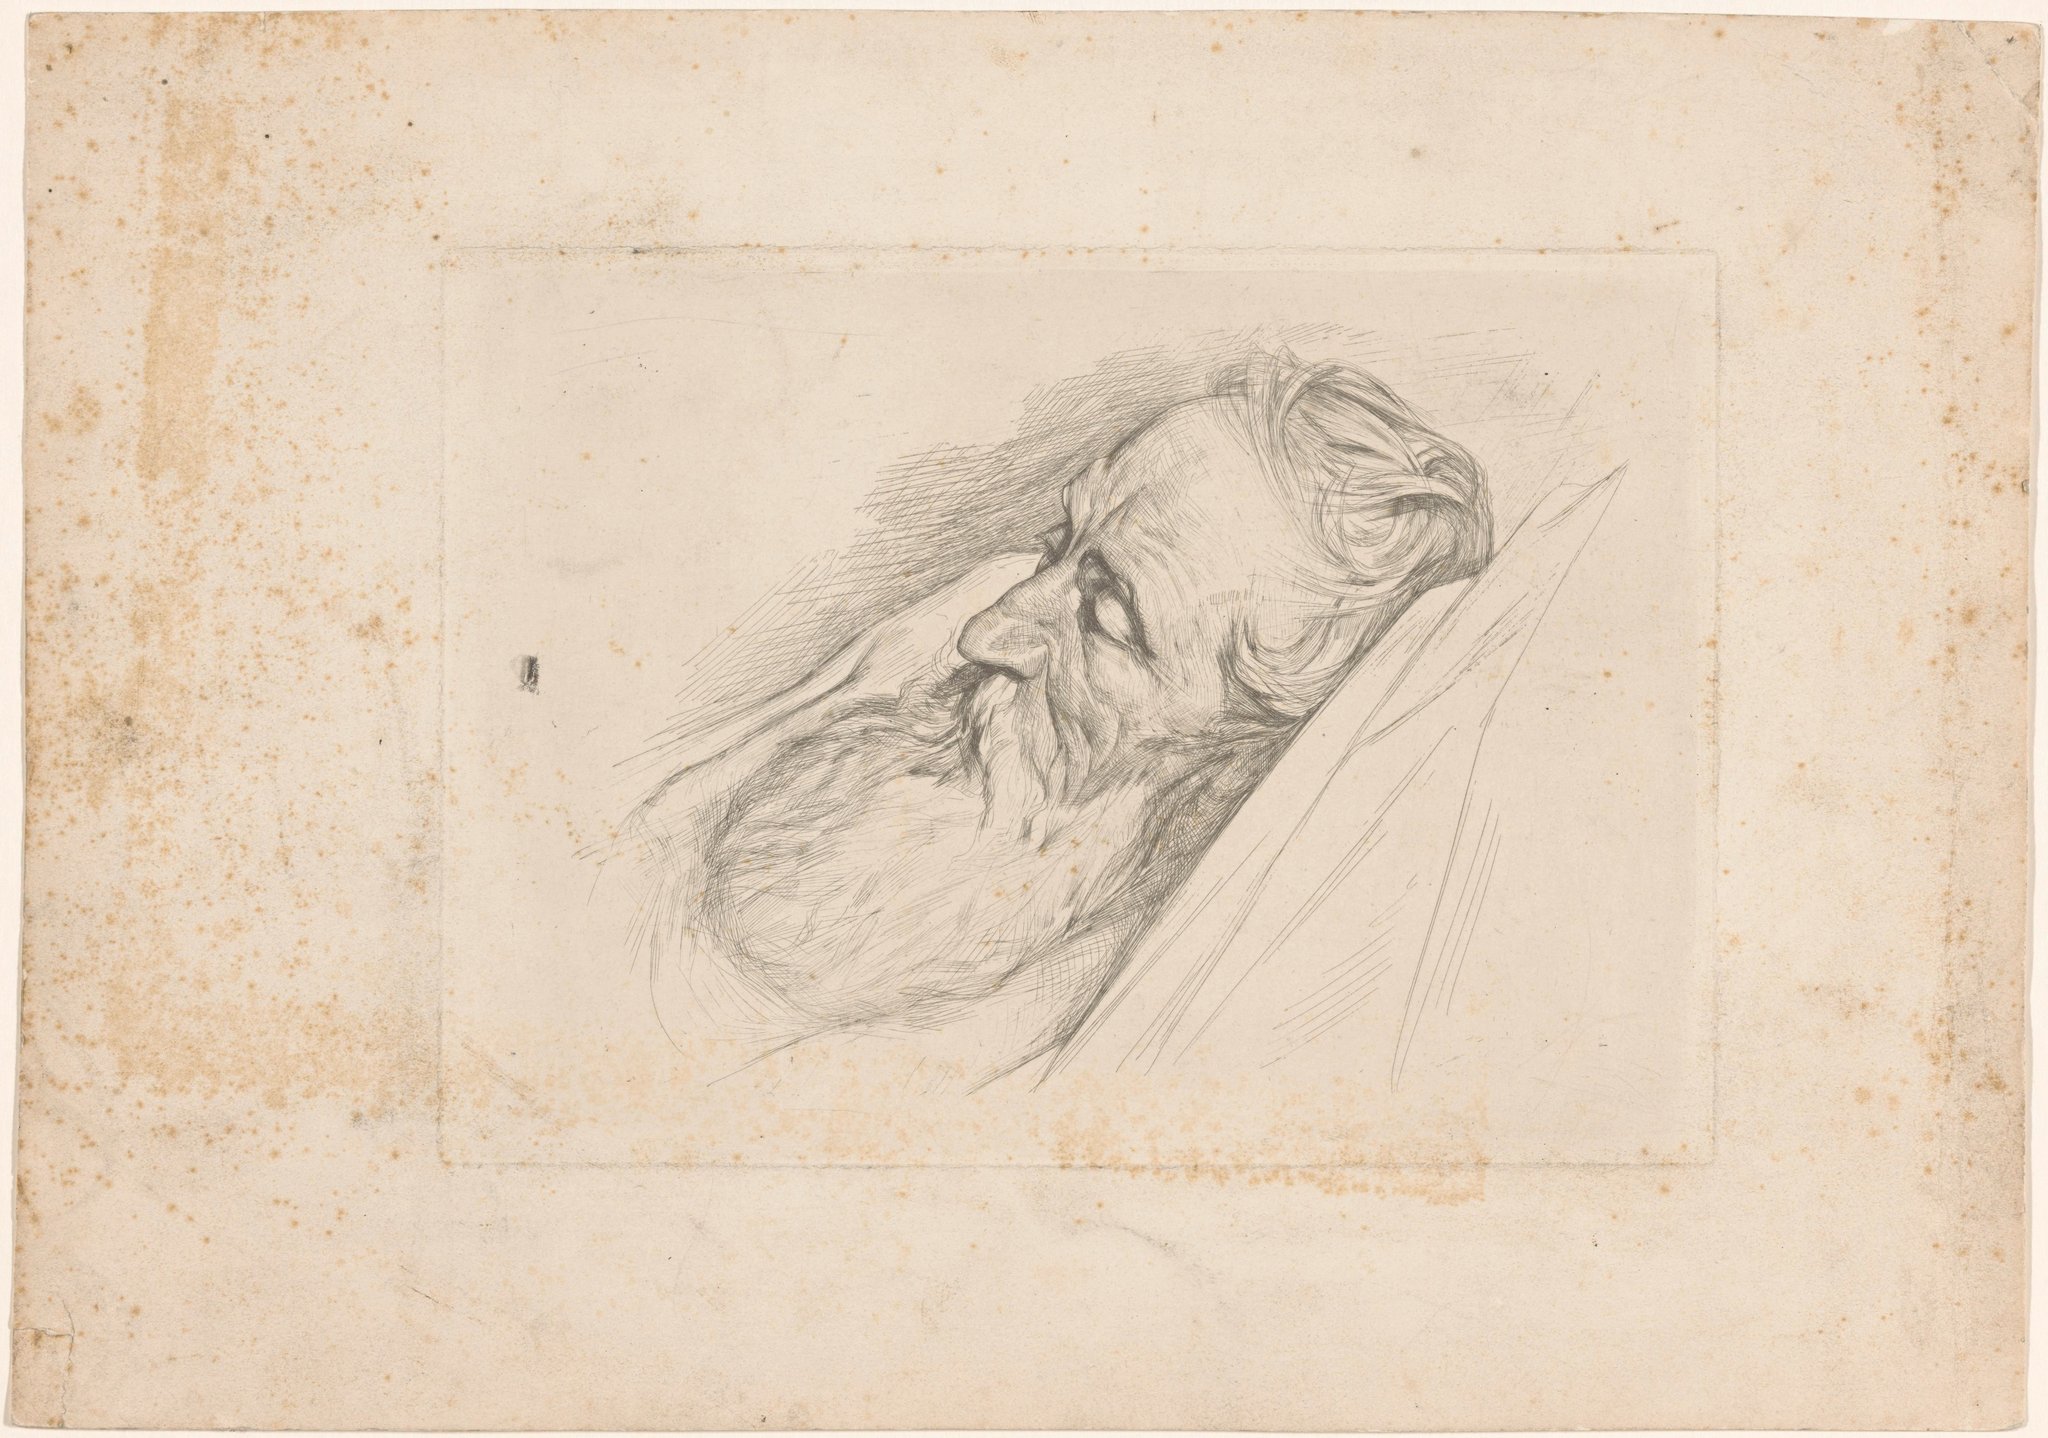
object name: print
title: Slapende man met baard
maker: antoon derkinderen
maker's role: draughtsman, painter, print maker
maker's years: 1859-1925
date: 1882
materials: paper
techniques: etching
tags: sleeping; unconsciousness, beard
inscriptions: collector's mark: Lugt 2228